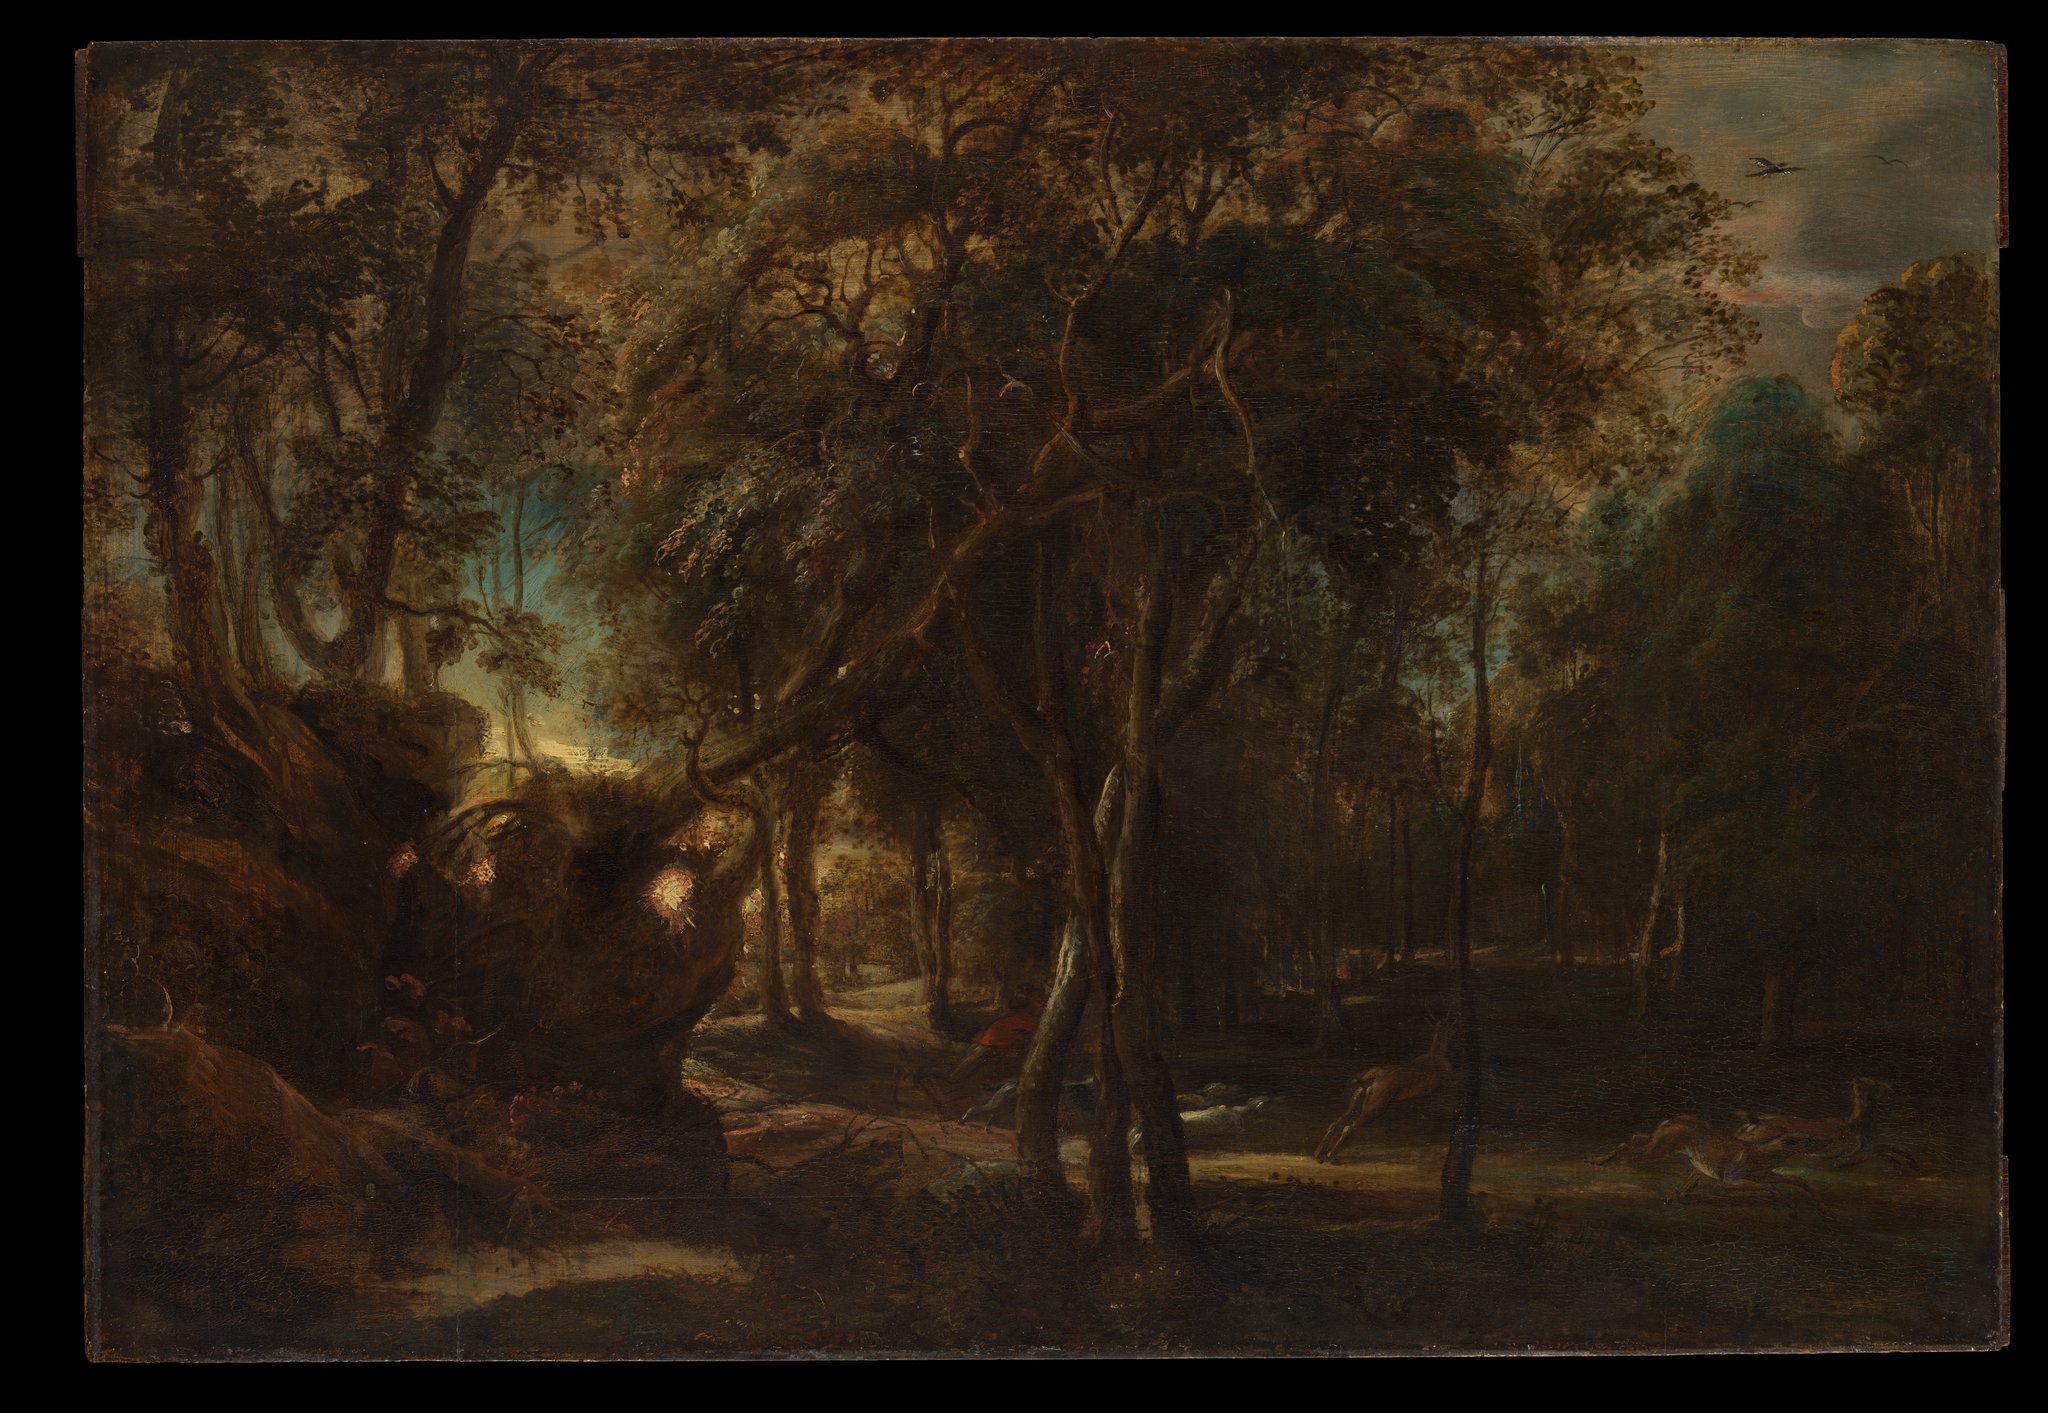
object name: painting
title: A Forest at Dawn with a Deer Hunt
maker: peter paul rubens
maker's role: artist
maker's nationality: flemish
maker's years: 1577-1640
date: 1635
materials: oil, wood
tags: hunting,deer,forests,dawn